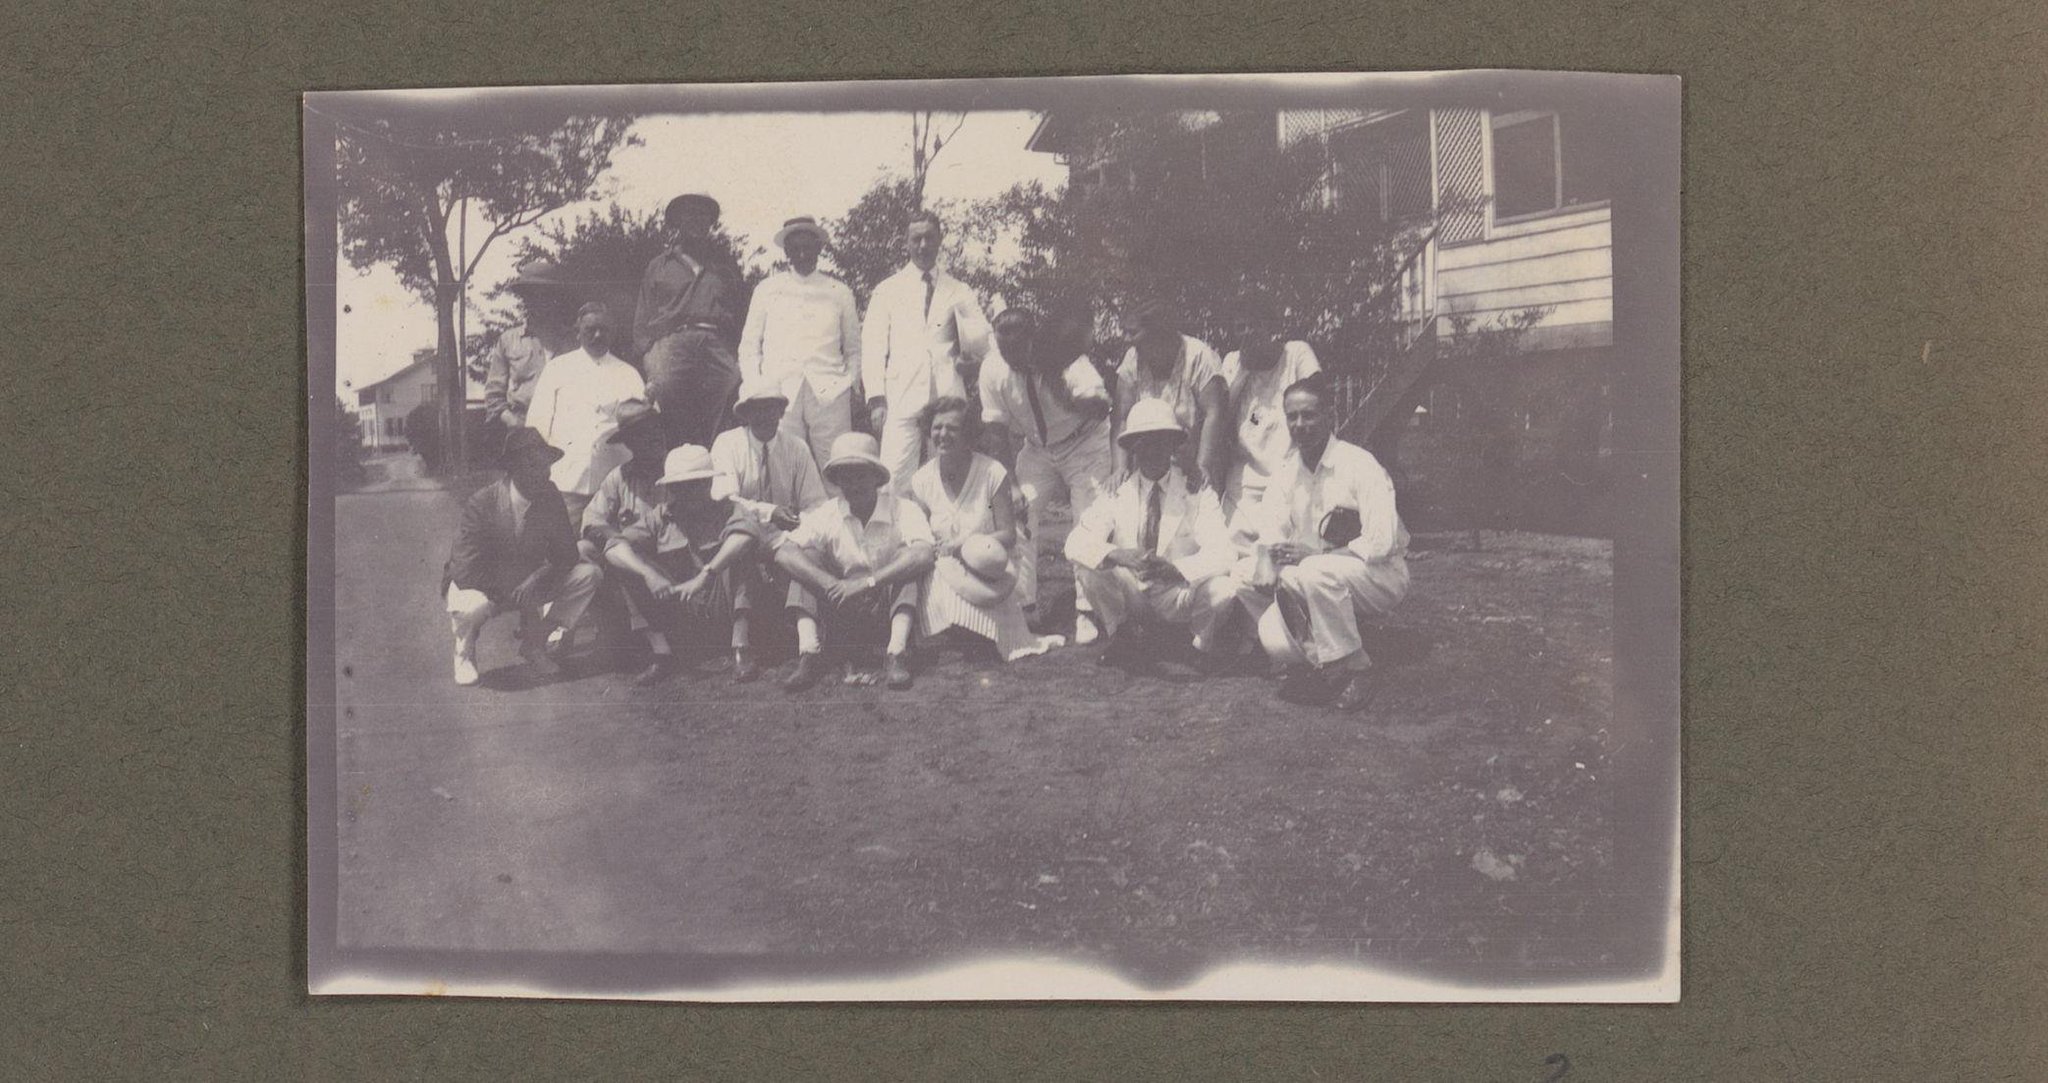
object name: photograph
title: Groepsfoto te Moengo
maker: Anonymous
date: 1925-1927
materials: photographic support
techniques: photography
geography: suriname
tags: jetten, familie, moengo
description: Groepsfoto te Moengo. Foto op een bladzijde van een los albumblad. Onderdeel van het ensemble met foto's van de familie van ingenieur Jetten in de mijnbouwstad Moengo in Suriname.